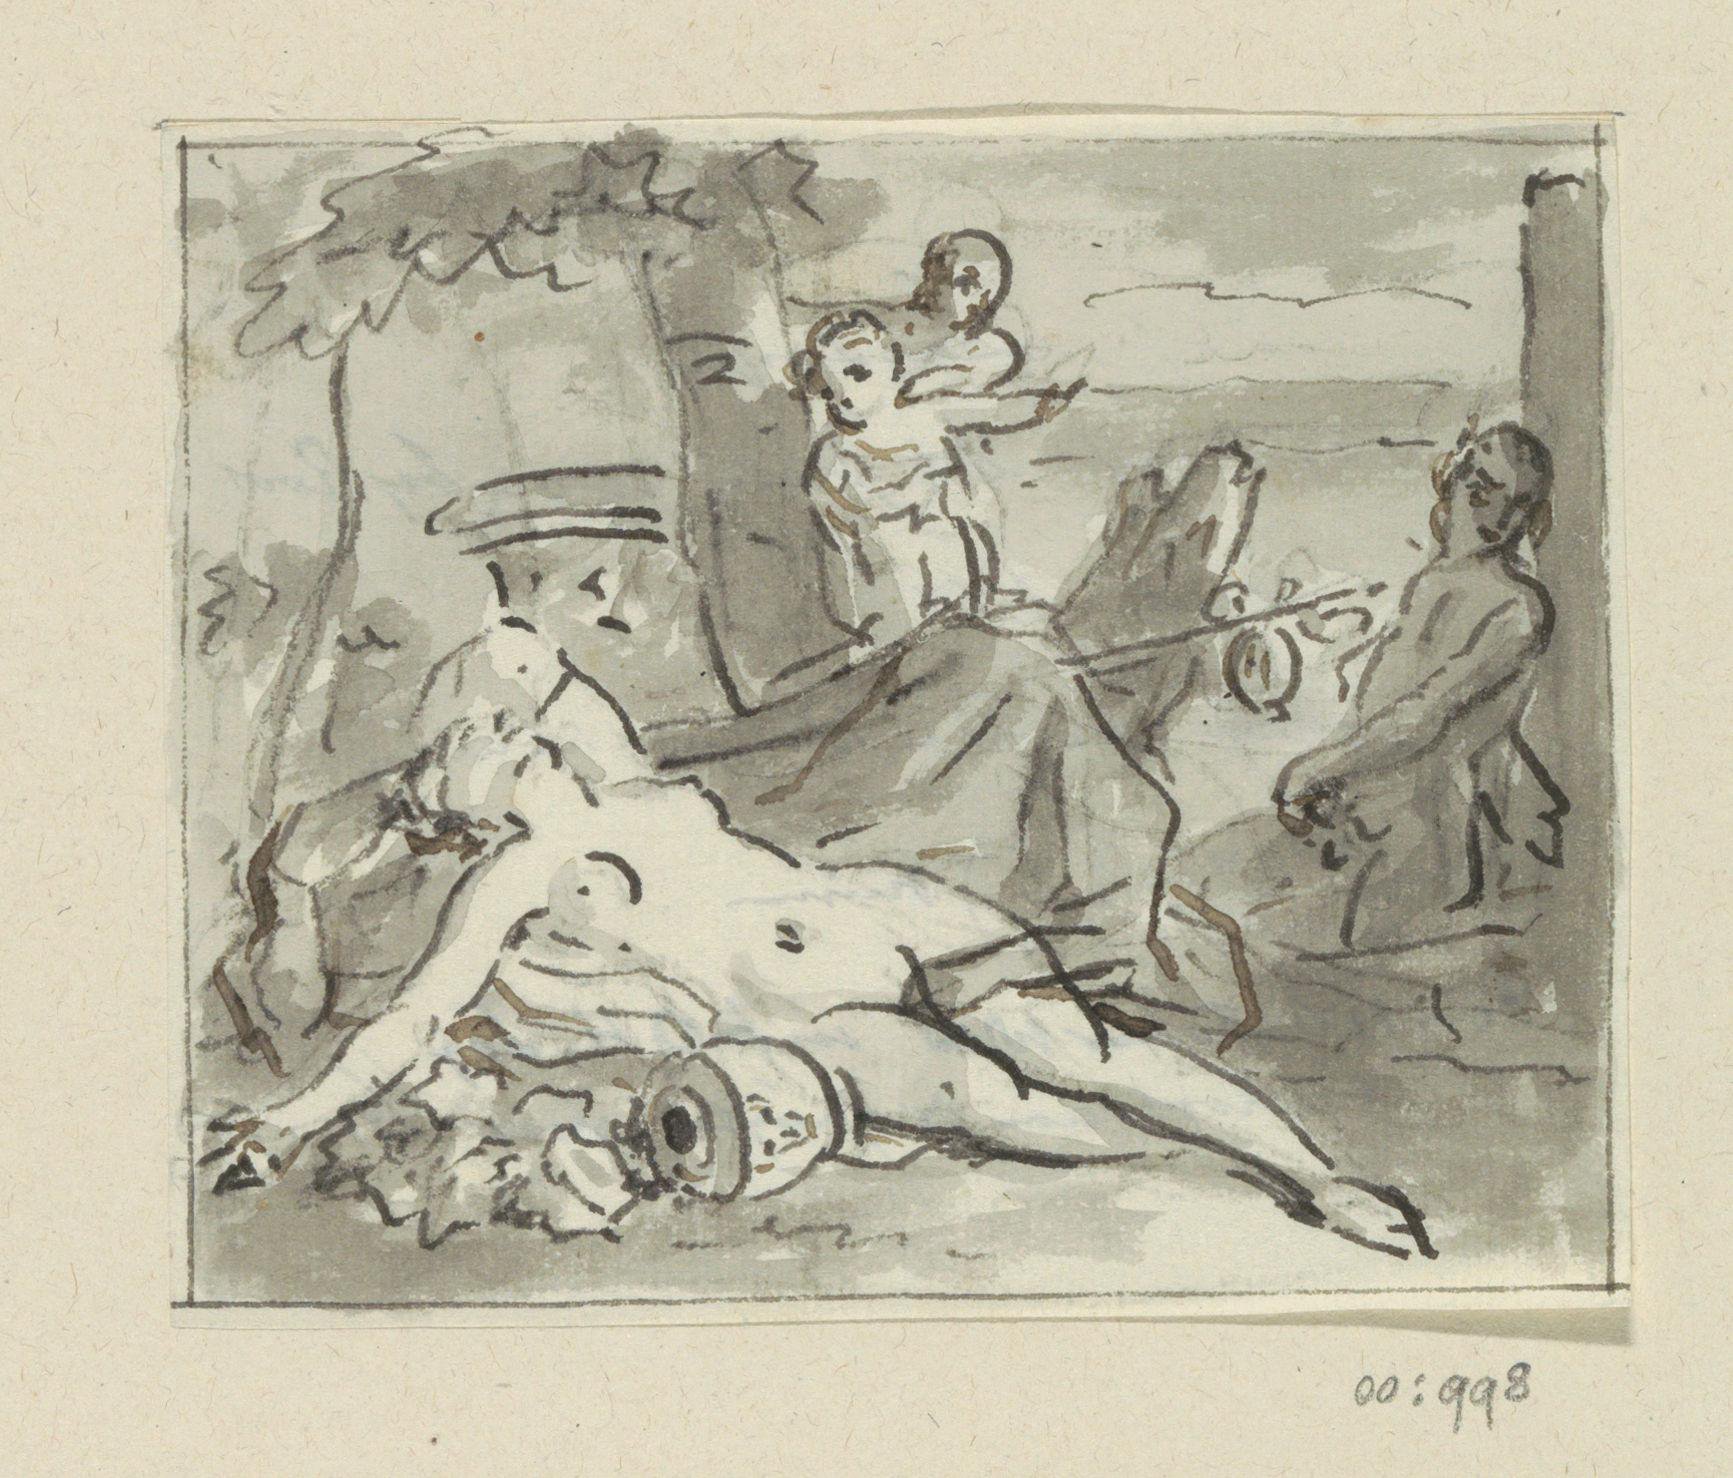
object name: album leaf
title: Slapende nimf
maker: jurriaan andriessen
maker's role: draughtsman, painter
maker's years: 1742-1819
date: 1760-1819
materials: paper, pencil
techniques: brush, pen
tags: nymphs (in general); 'ninfe in commune' (ripa)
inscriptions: inscription: ‘deze Lairesse/ verkogt 24 july 1804 by Roos/ voor f 70/ hoog 57/ breed 74 duimen/ den 11 october 1810 in t O.H. log/ verkogt aan de gruijter voor f 61.’